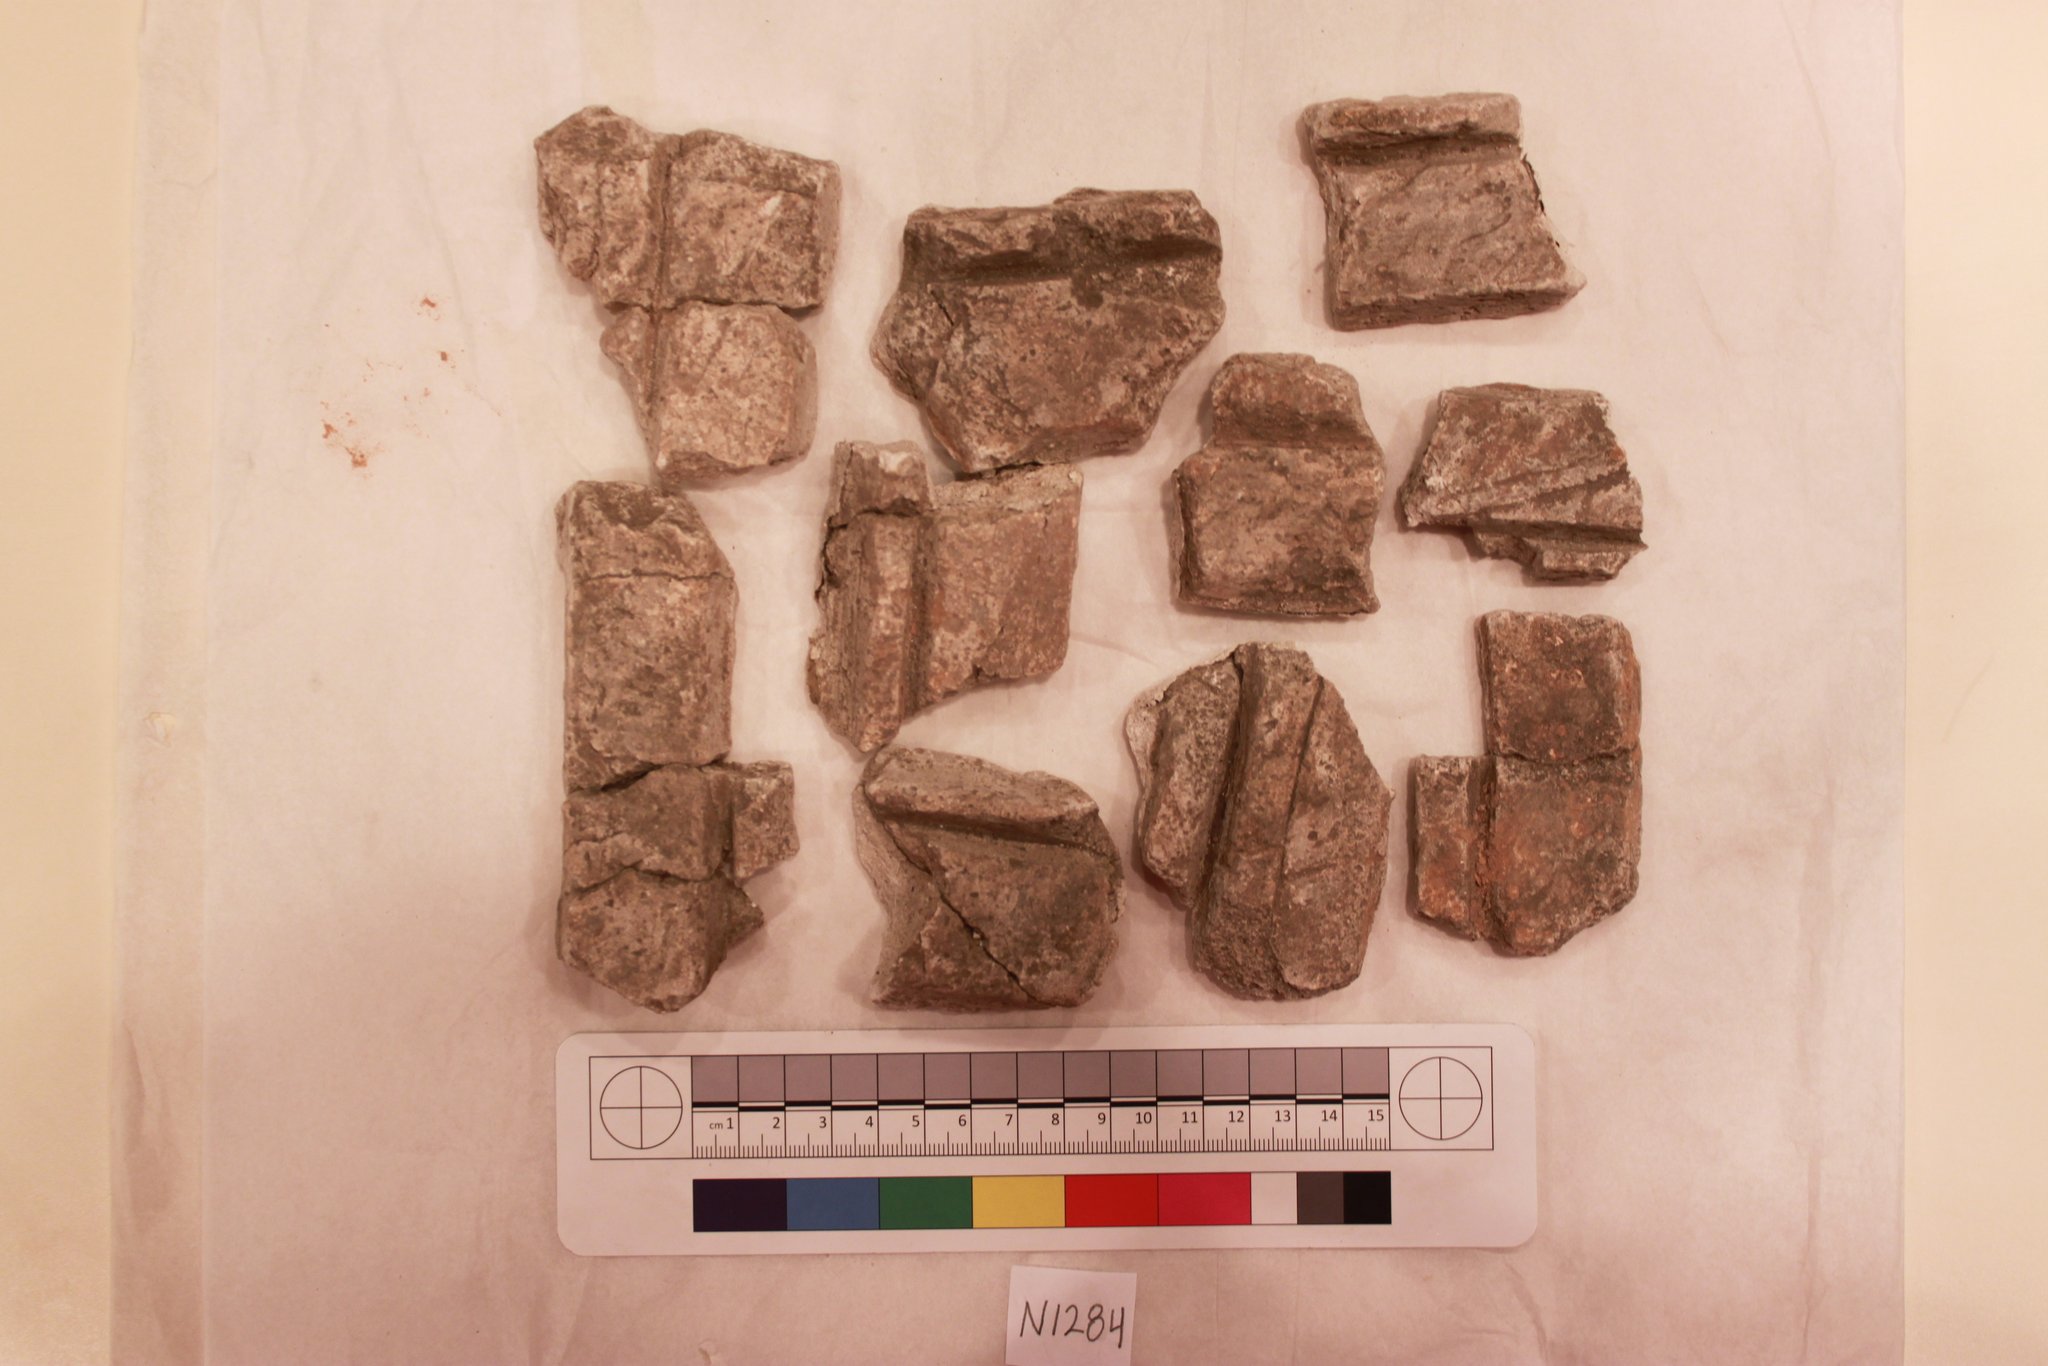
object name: fragment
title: Stucco Fragment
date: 701-1200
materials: plaster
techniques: carving, painting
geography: iran